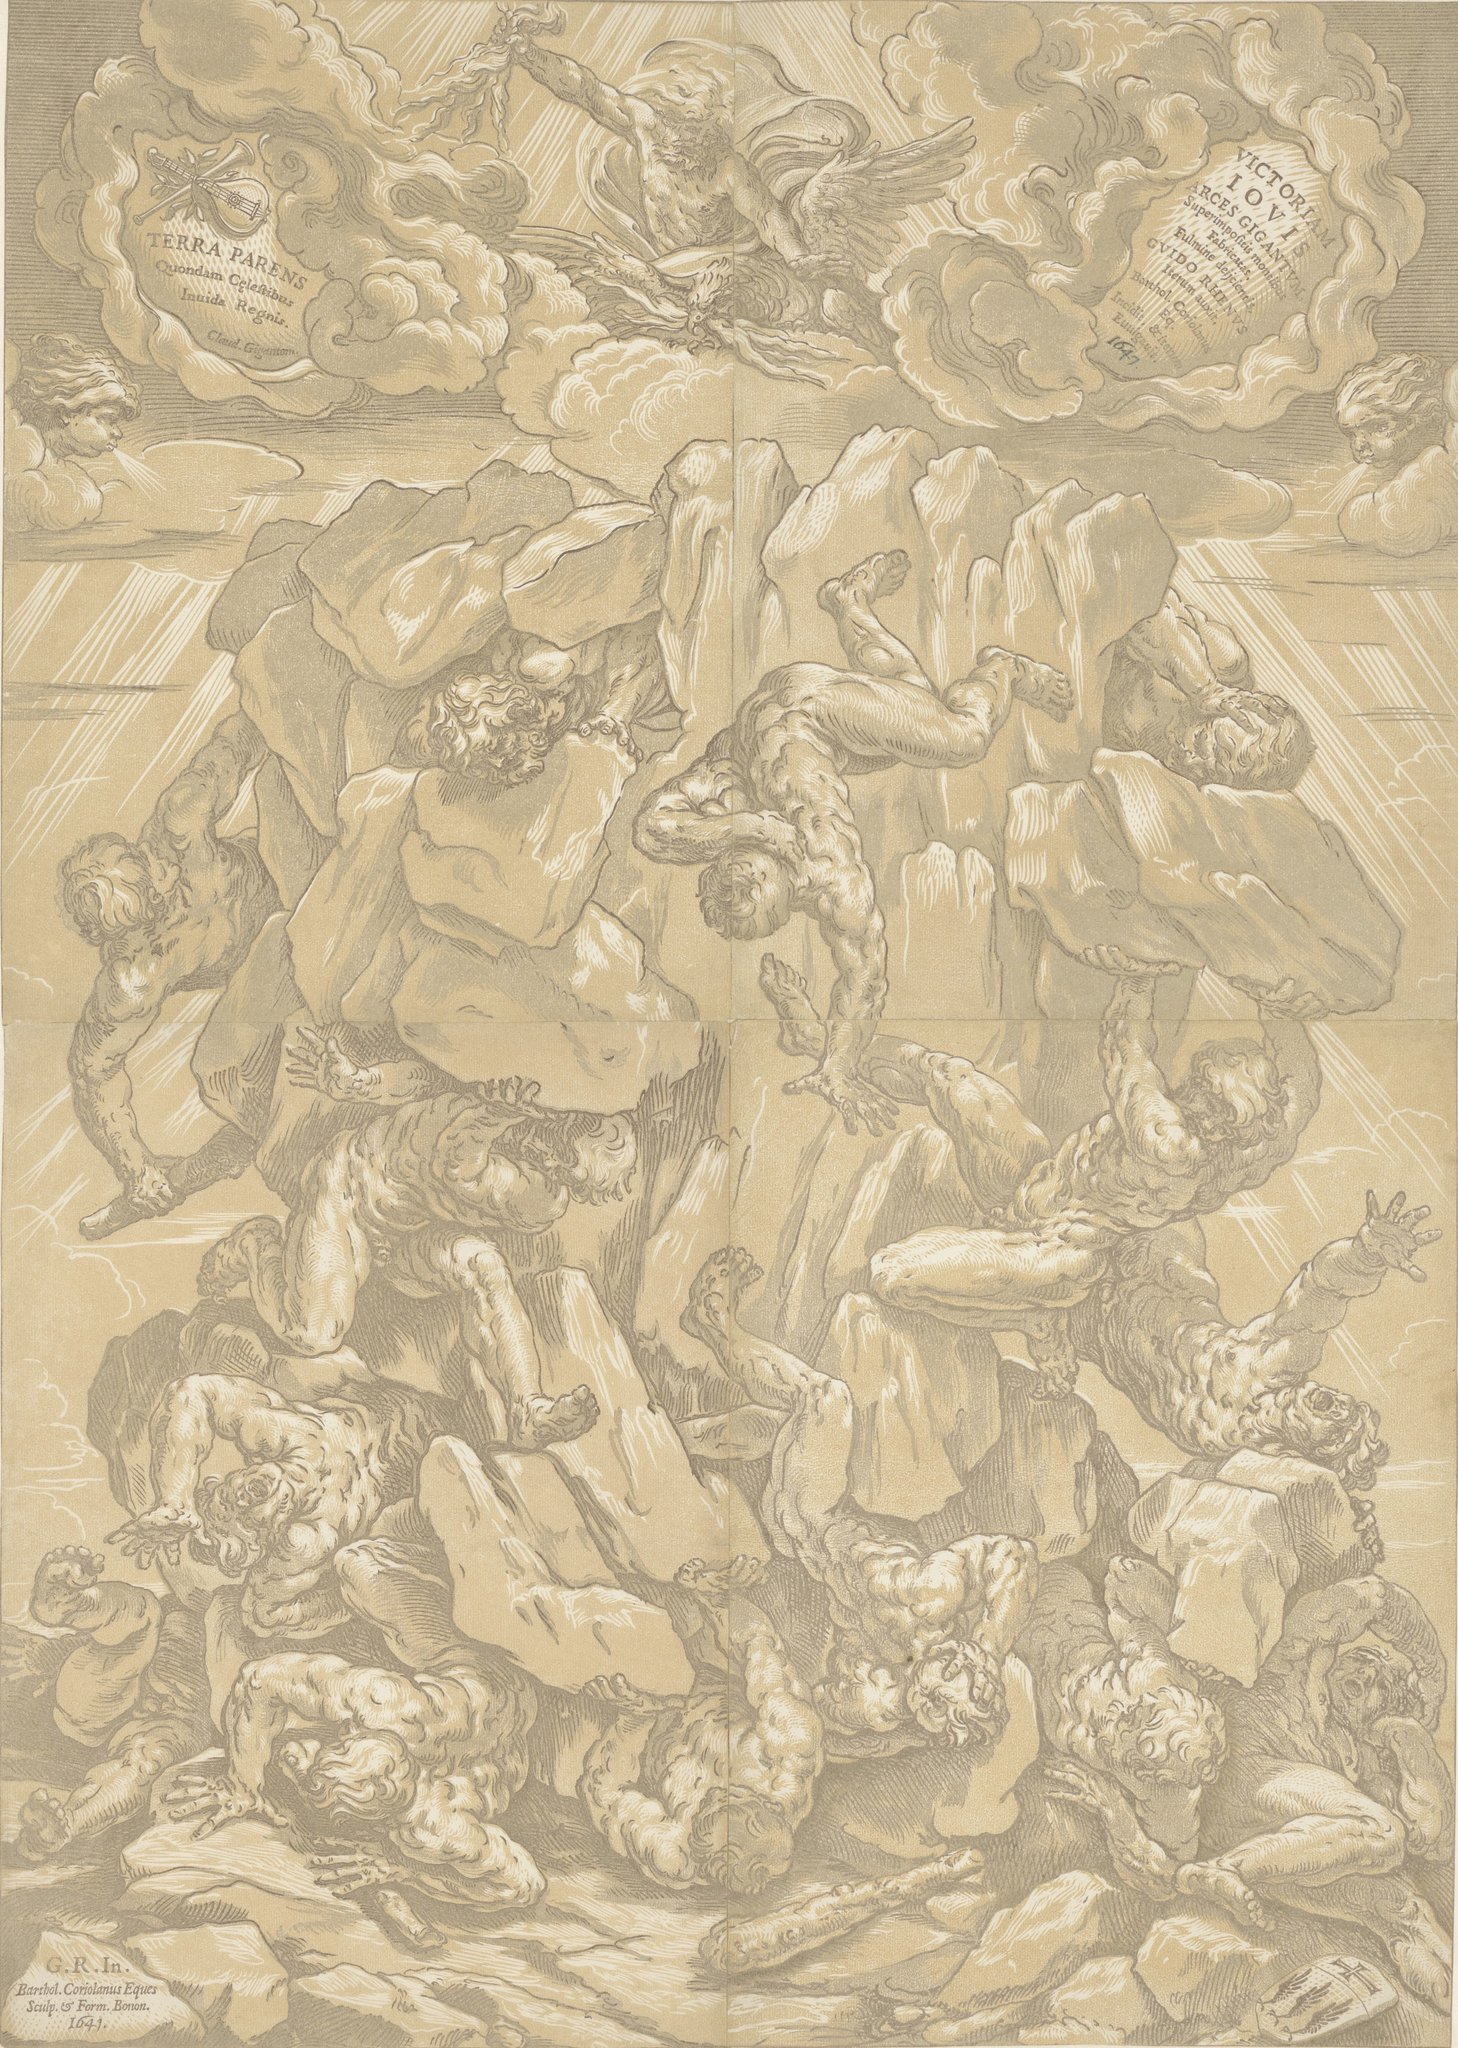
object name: print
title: Val van de giganten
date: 1641-1647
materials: paper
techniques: woodcut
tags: war of the titans against jupiter and allies: titanomachy, (story of) jupiter (zeus), giants, colossi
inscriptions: collector's mark: Lugt 240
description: De giganten die de hemel bestormden om Jupiter ten val te brengen, worden onder stenen bedolven. Bovenaan de woedende Jupiter met adelaar en bliksemschichten.